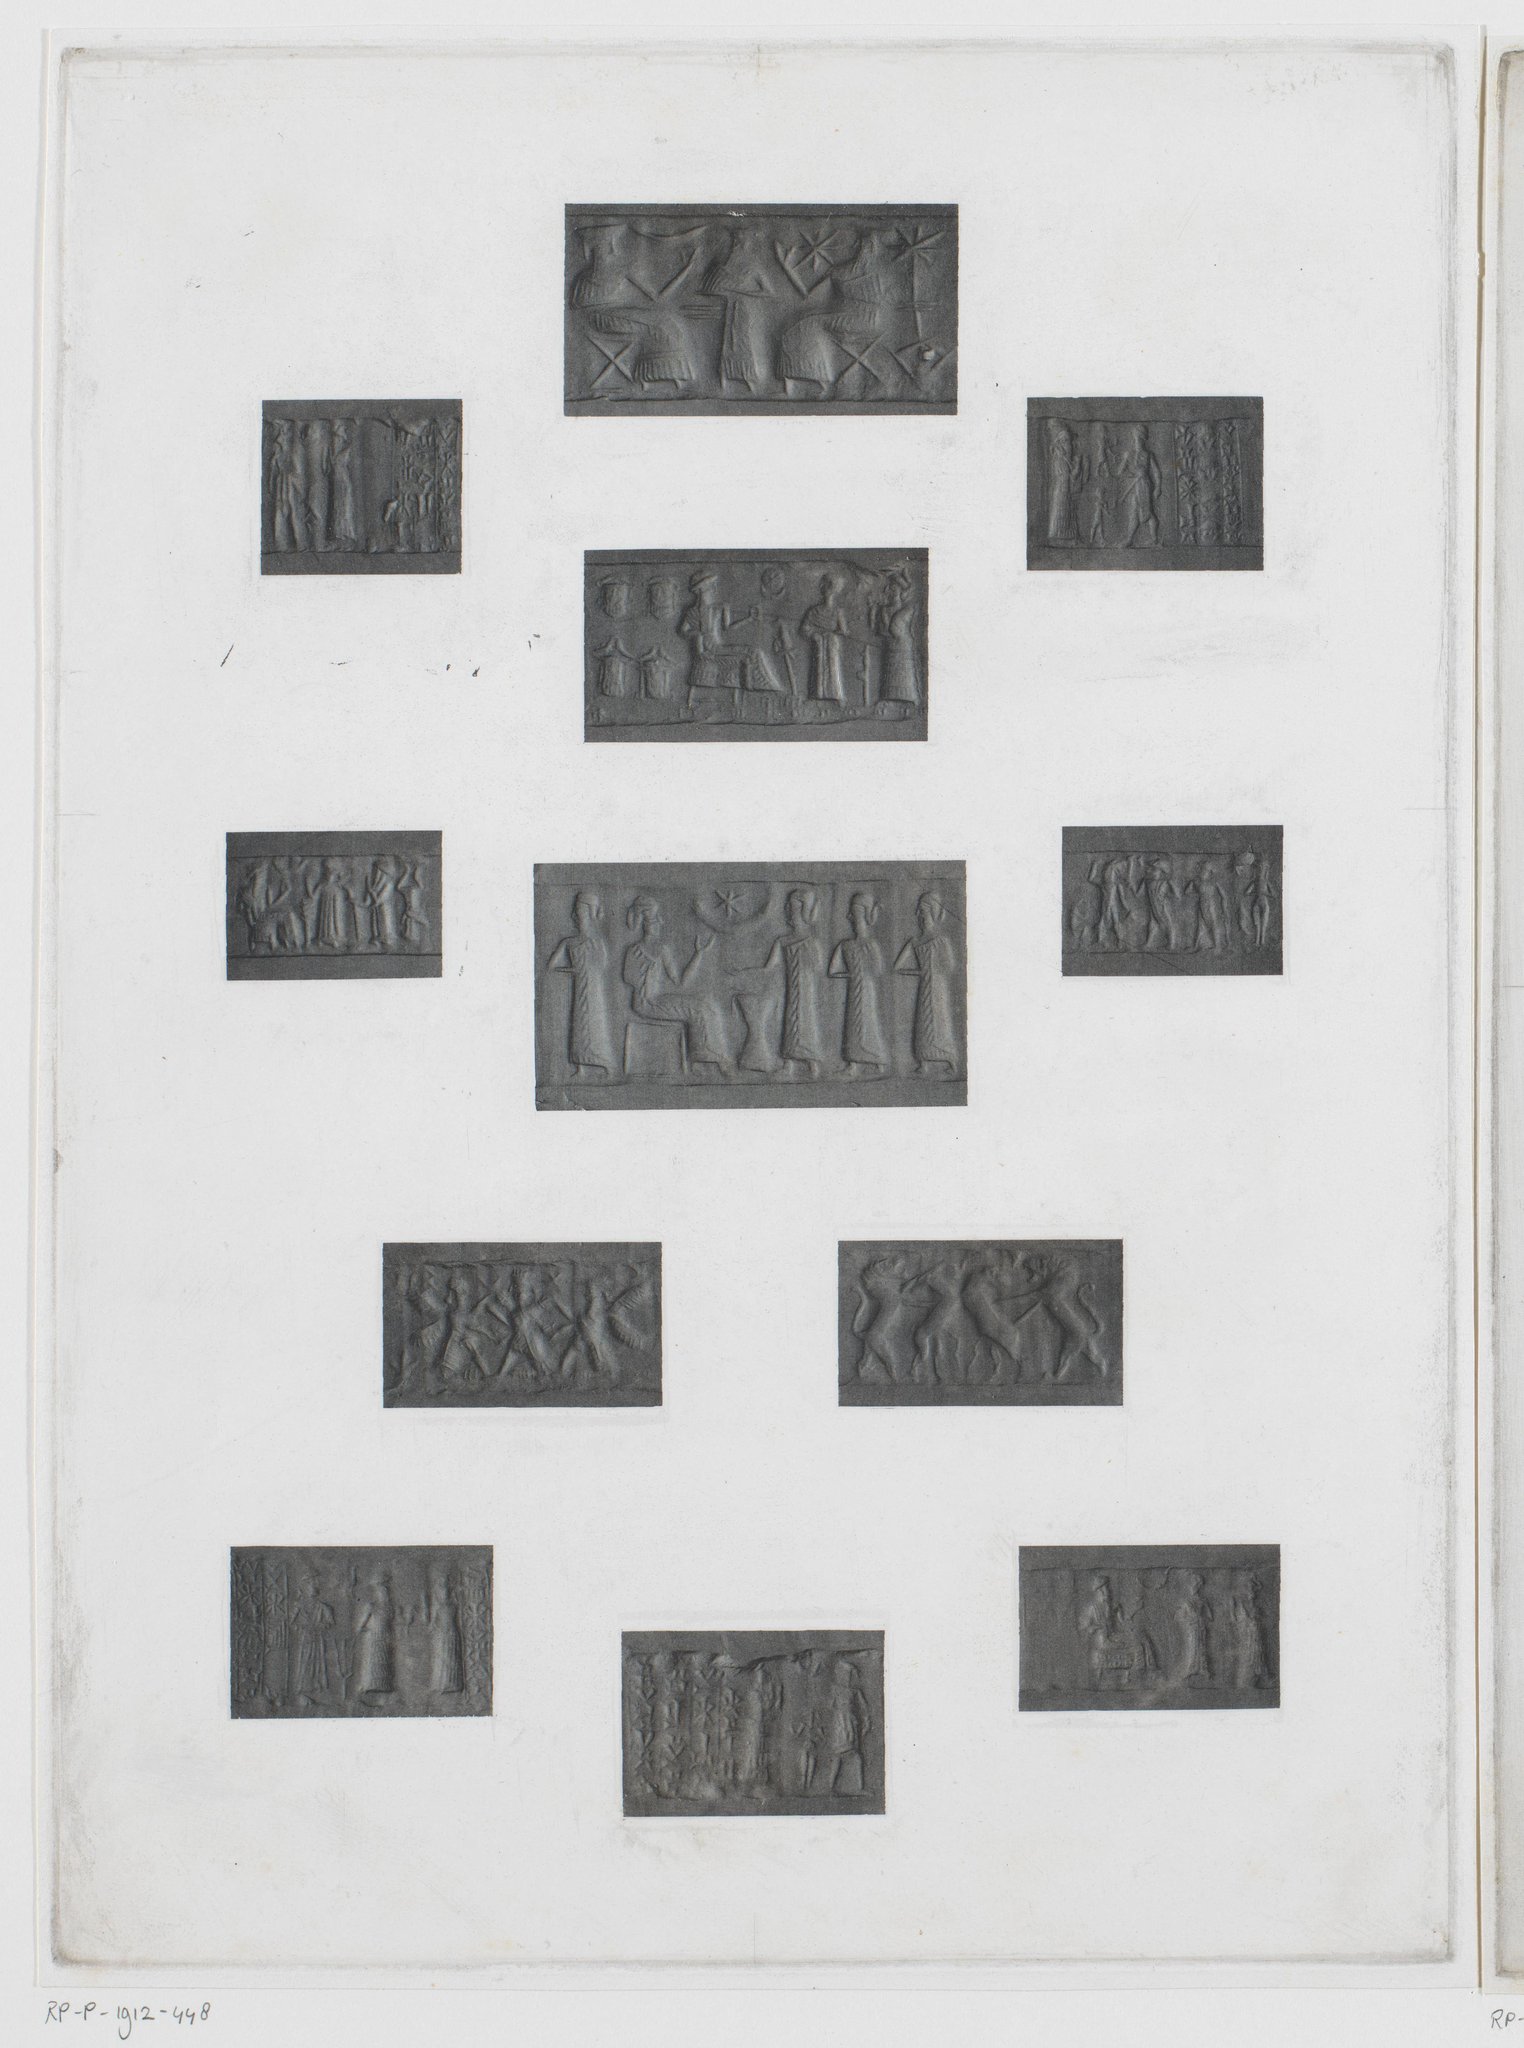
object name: print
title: Twaalf rechthoekige gesneden stenen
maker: jan dam steuerwald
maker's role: print maker, printer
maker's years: 1805-1869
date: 1839-1863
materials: paper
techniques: relief engraving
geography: netherlands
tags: piece of sculpture, reproduction of a piece of sculpture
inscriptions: collector's mark: Lugt 2228